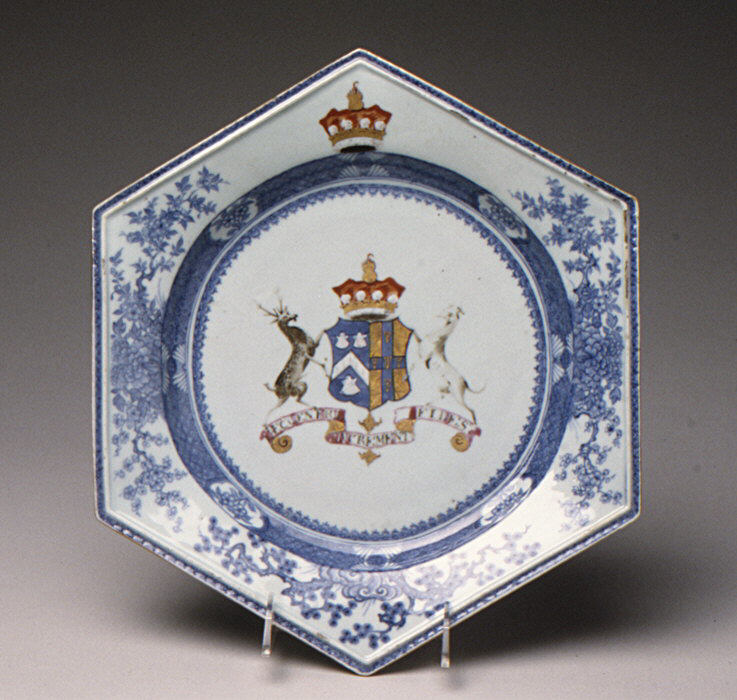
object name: dish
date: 1725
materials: hard paste porcelain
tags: plants,coat of arms